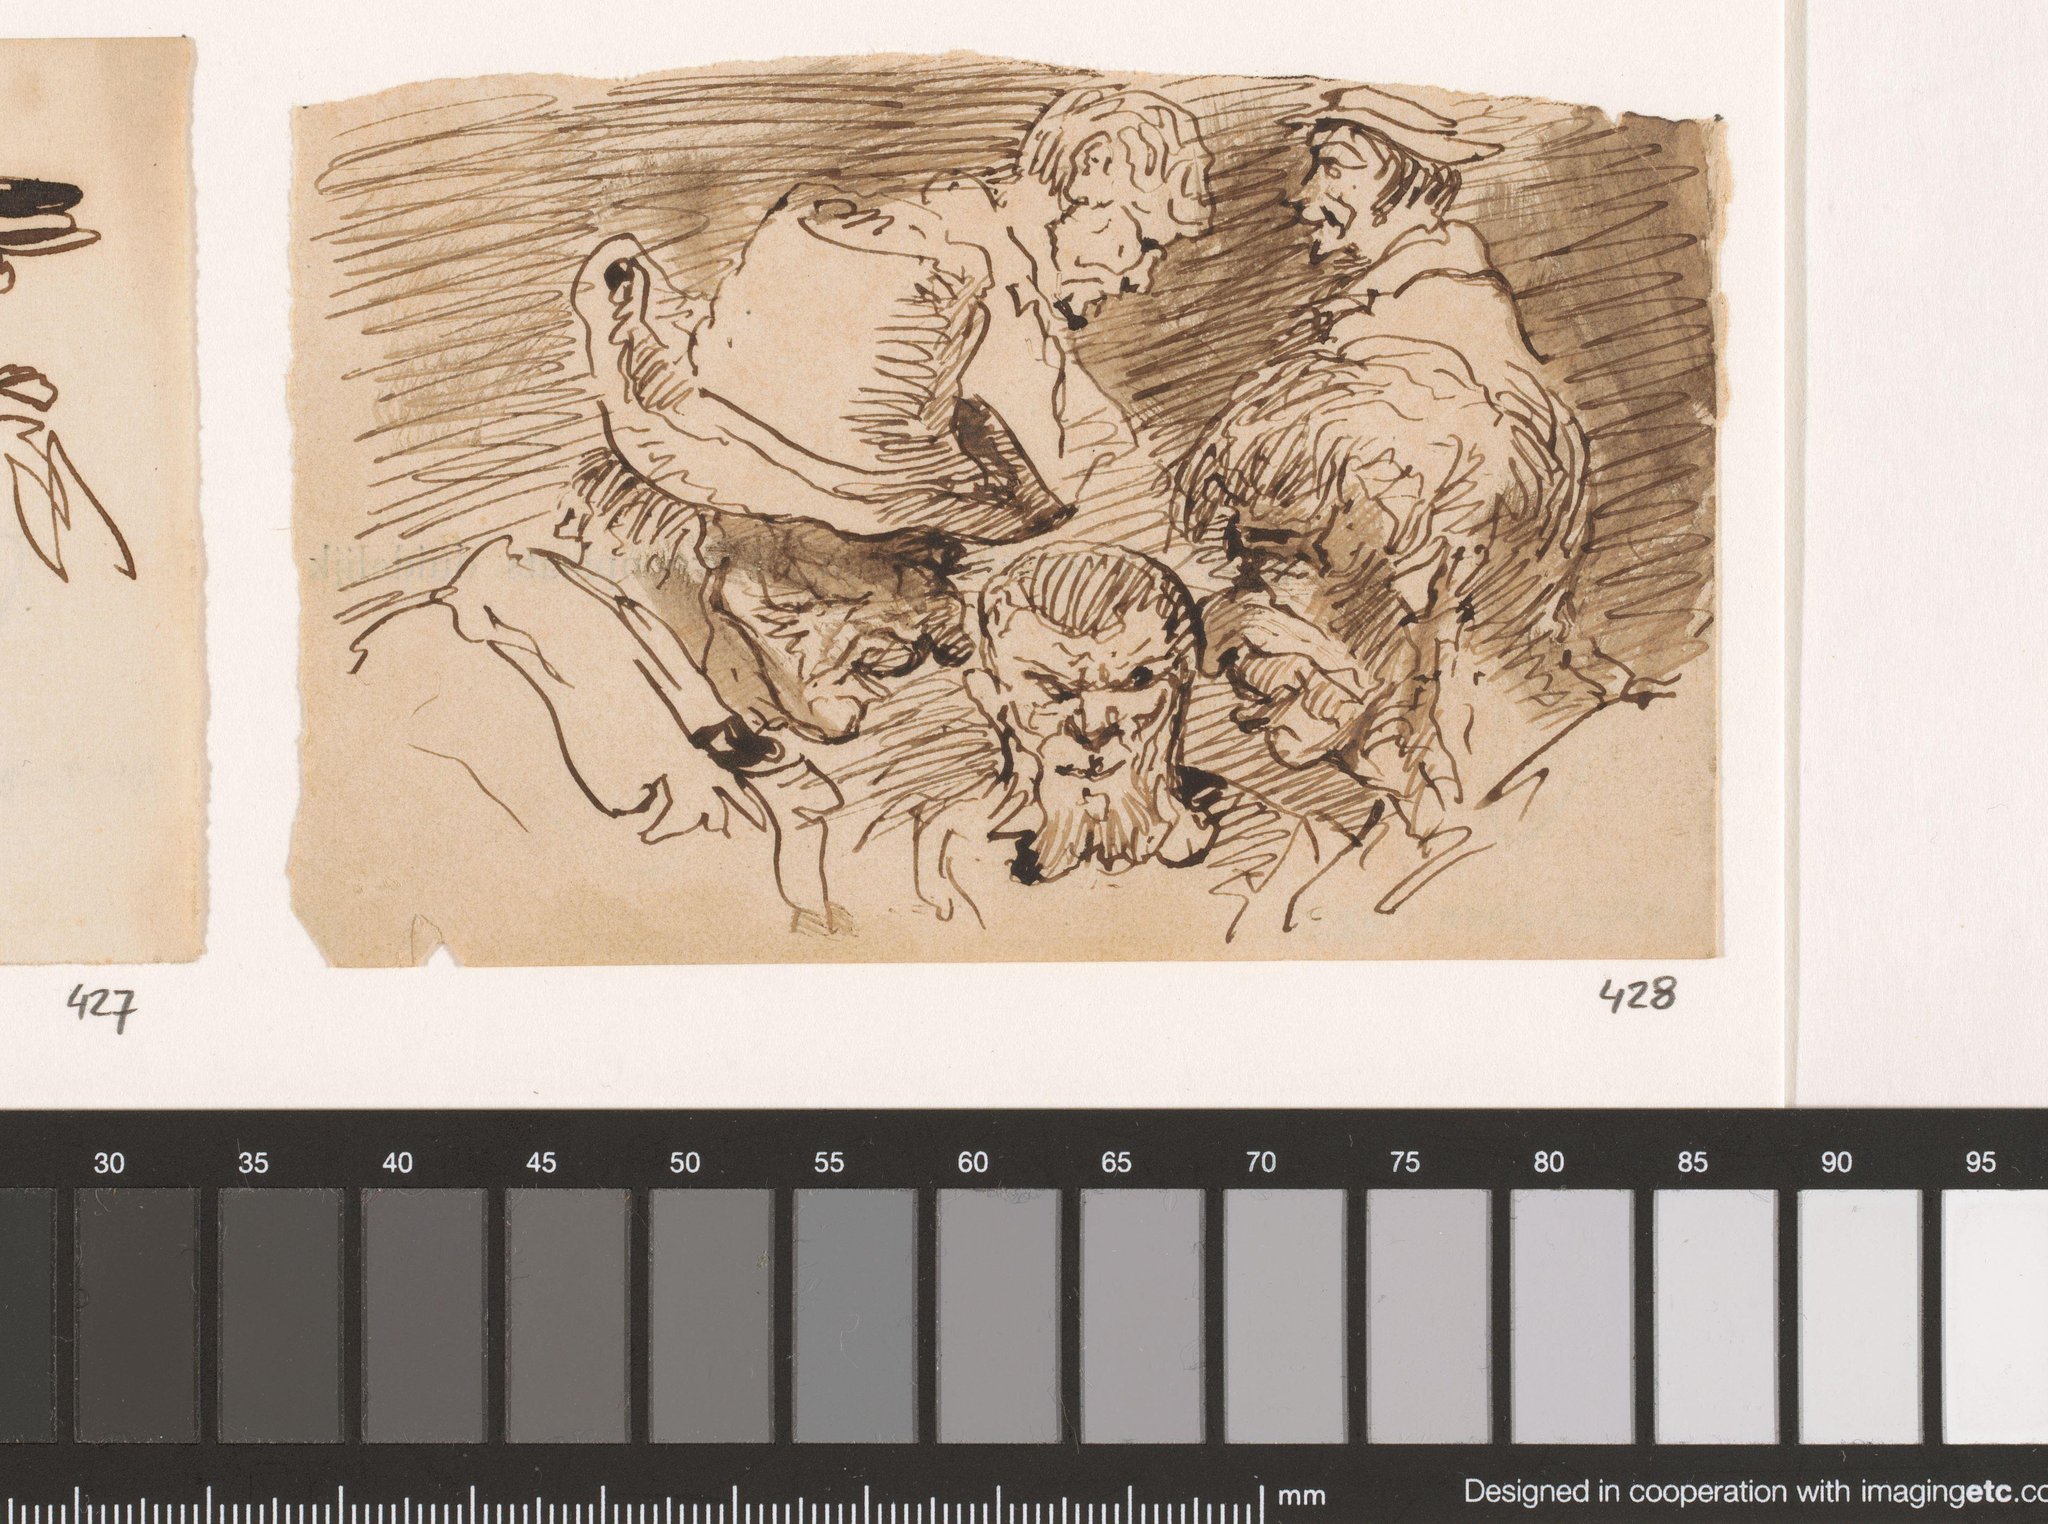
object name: drawing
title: Koppen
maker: johannes tavenraat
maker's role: draughtsman, painter, print maker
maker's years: 1809-1881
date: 1840-1880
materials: ink, paper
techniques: brush, pen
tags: caricatures (human types)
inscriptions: collector's mark: Lugt 2228